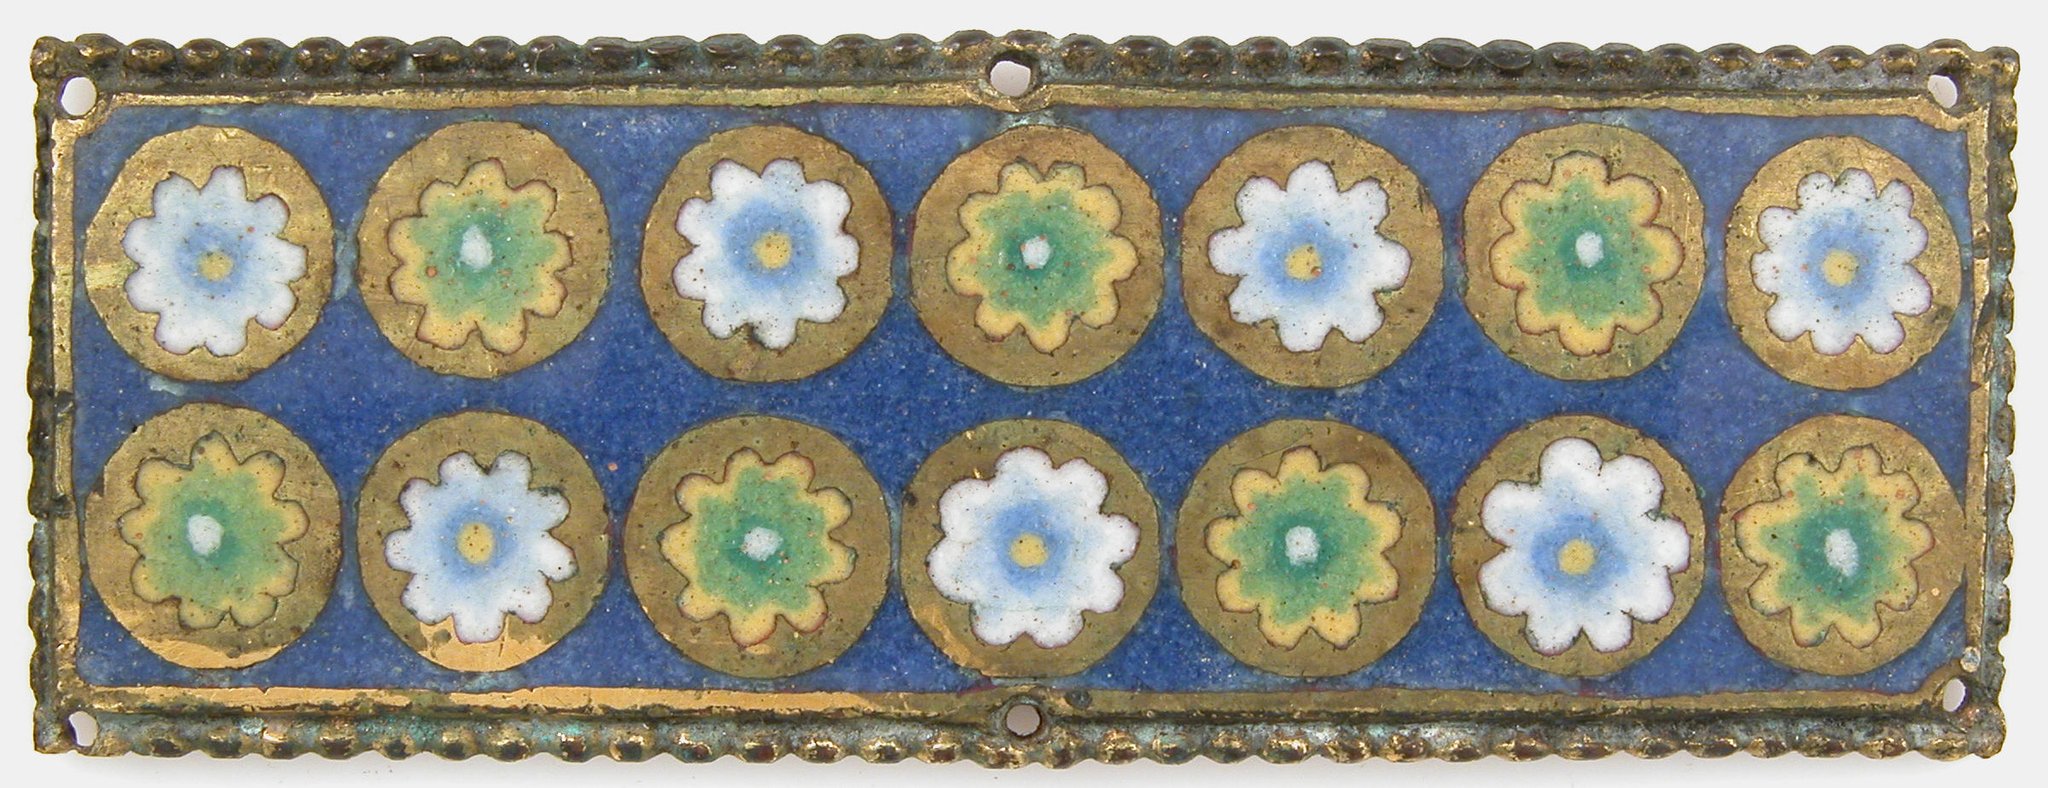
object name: plaque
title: Plaque from a Reliquary Shrine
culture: german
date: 1185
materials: copper alloy, enamel, gilt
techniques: enamel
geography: germany